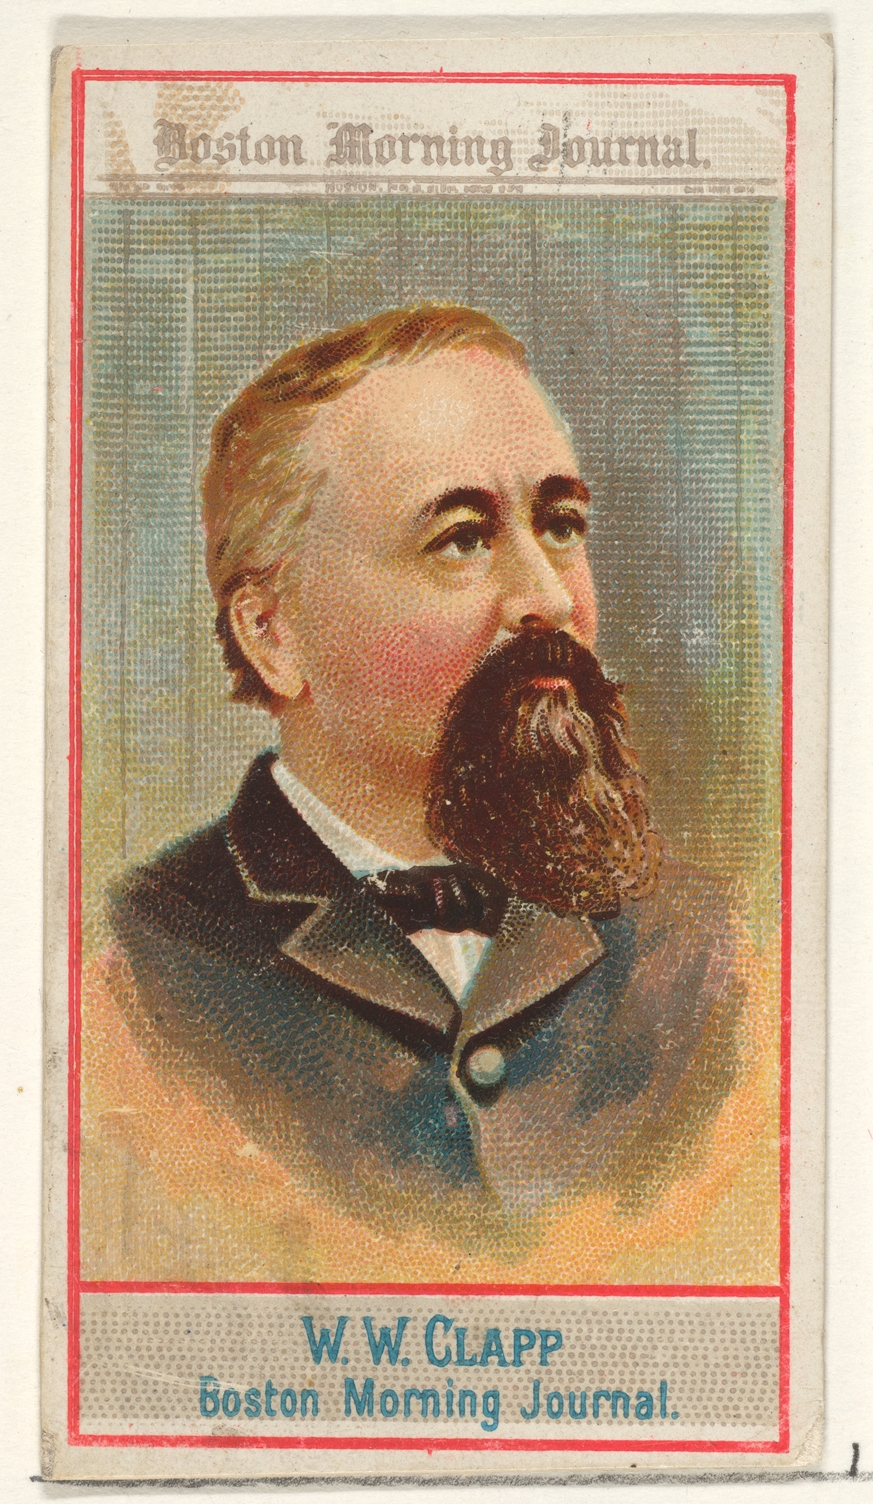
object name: print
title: W.W. Clapp, Boston Morning Journal, from the American Editors series (N1) for Allen & Ginter Cigarettes Brands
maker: allen & ginter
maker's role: publisher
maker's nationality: american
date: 1887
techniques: color lithograph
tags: men,portraits